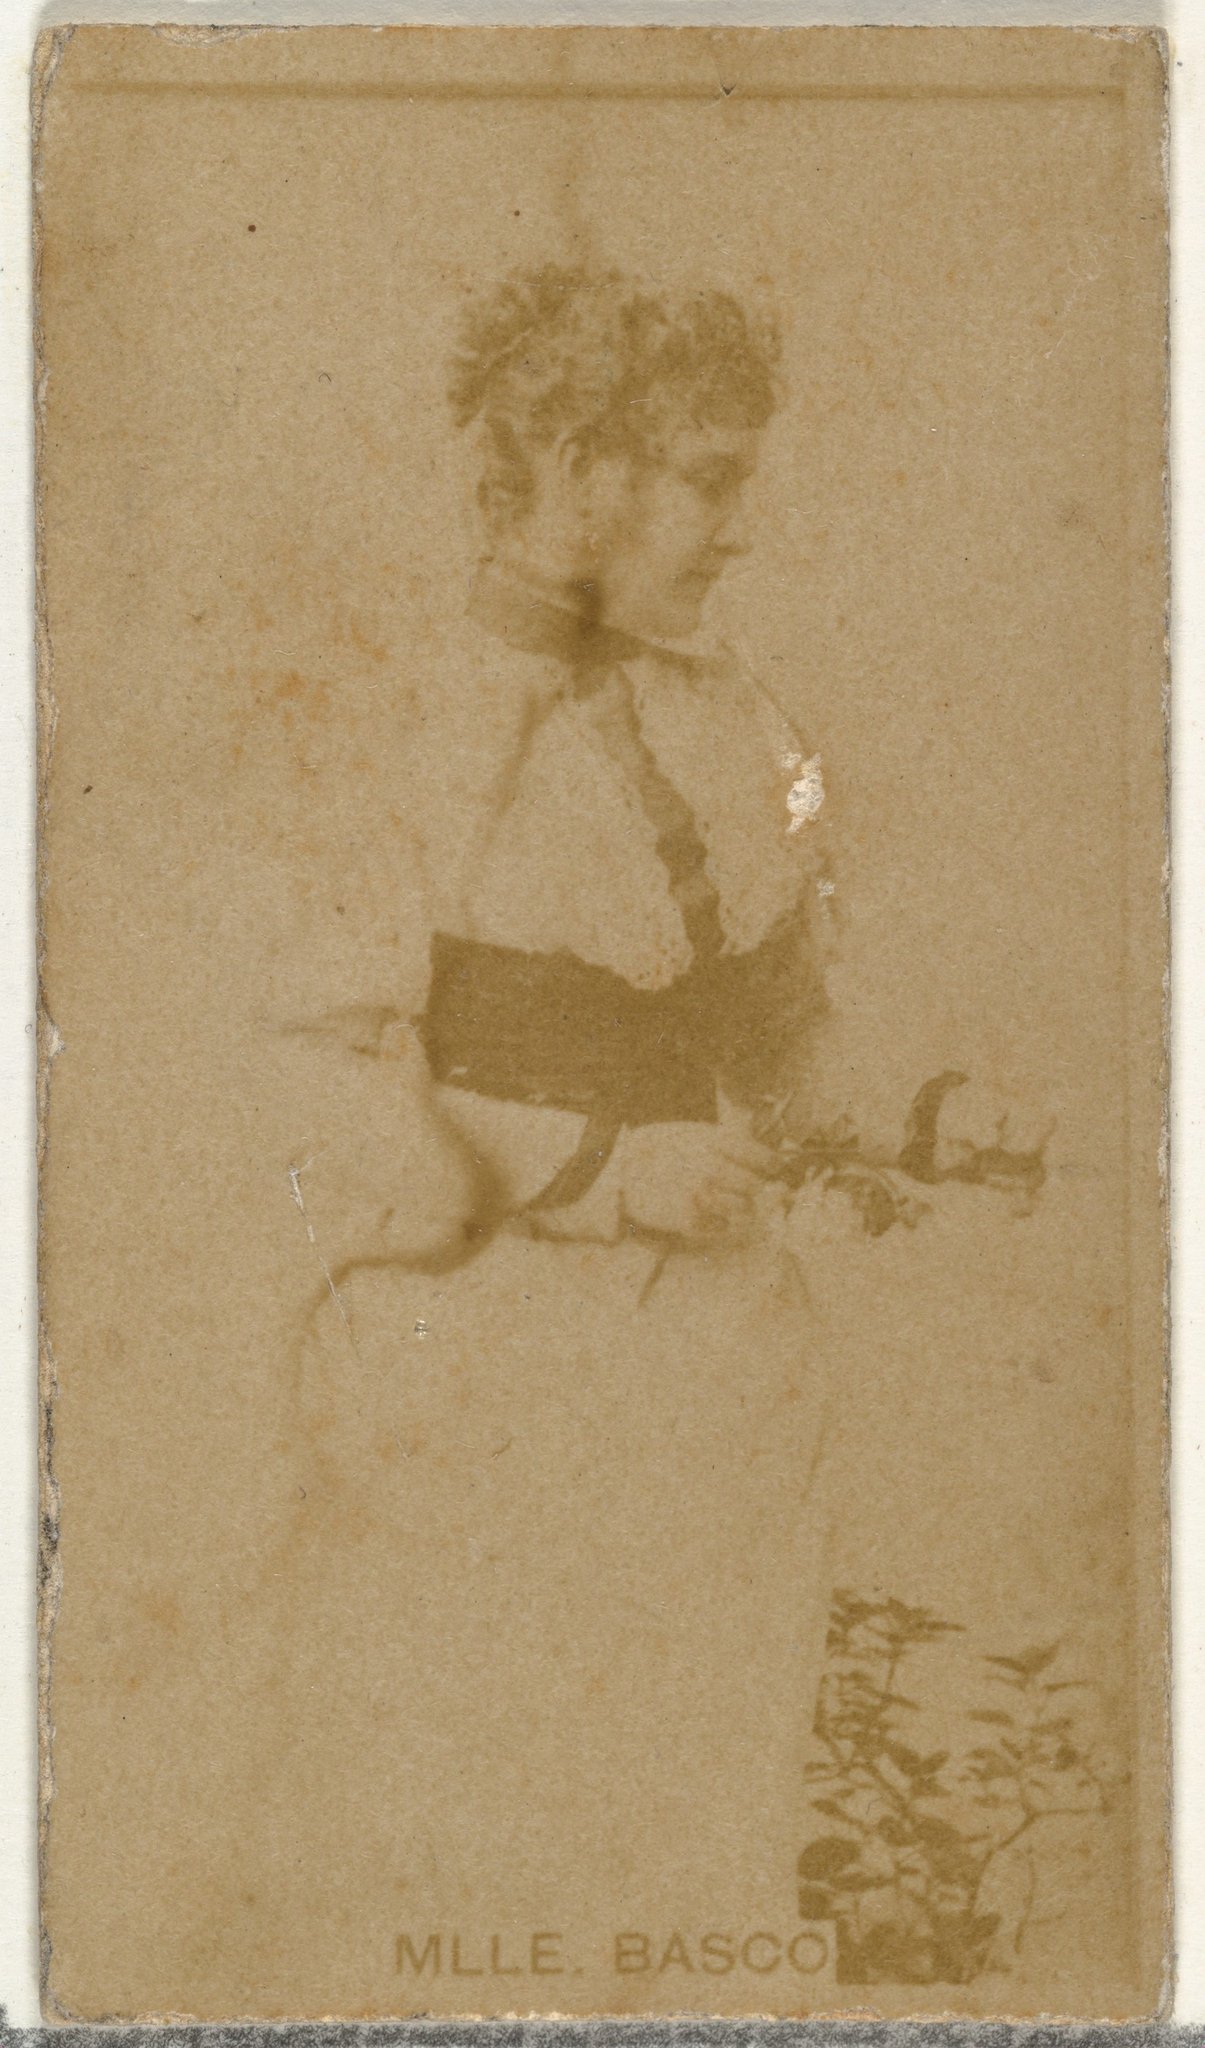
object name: photograph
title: Mlle. Basco, from the Actors and Actresses series (N145-8) issued by Duke Sons & Co. to promote Duke Cigarettes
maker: w. duke, sons & co.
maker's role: publisher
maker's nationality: american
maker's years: 1870-1920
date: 1891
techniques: albumen silver print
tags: portraits,women,actresses